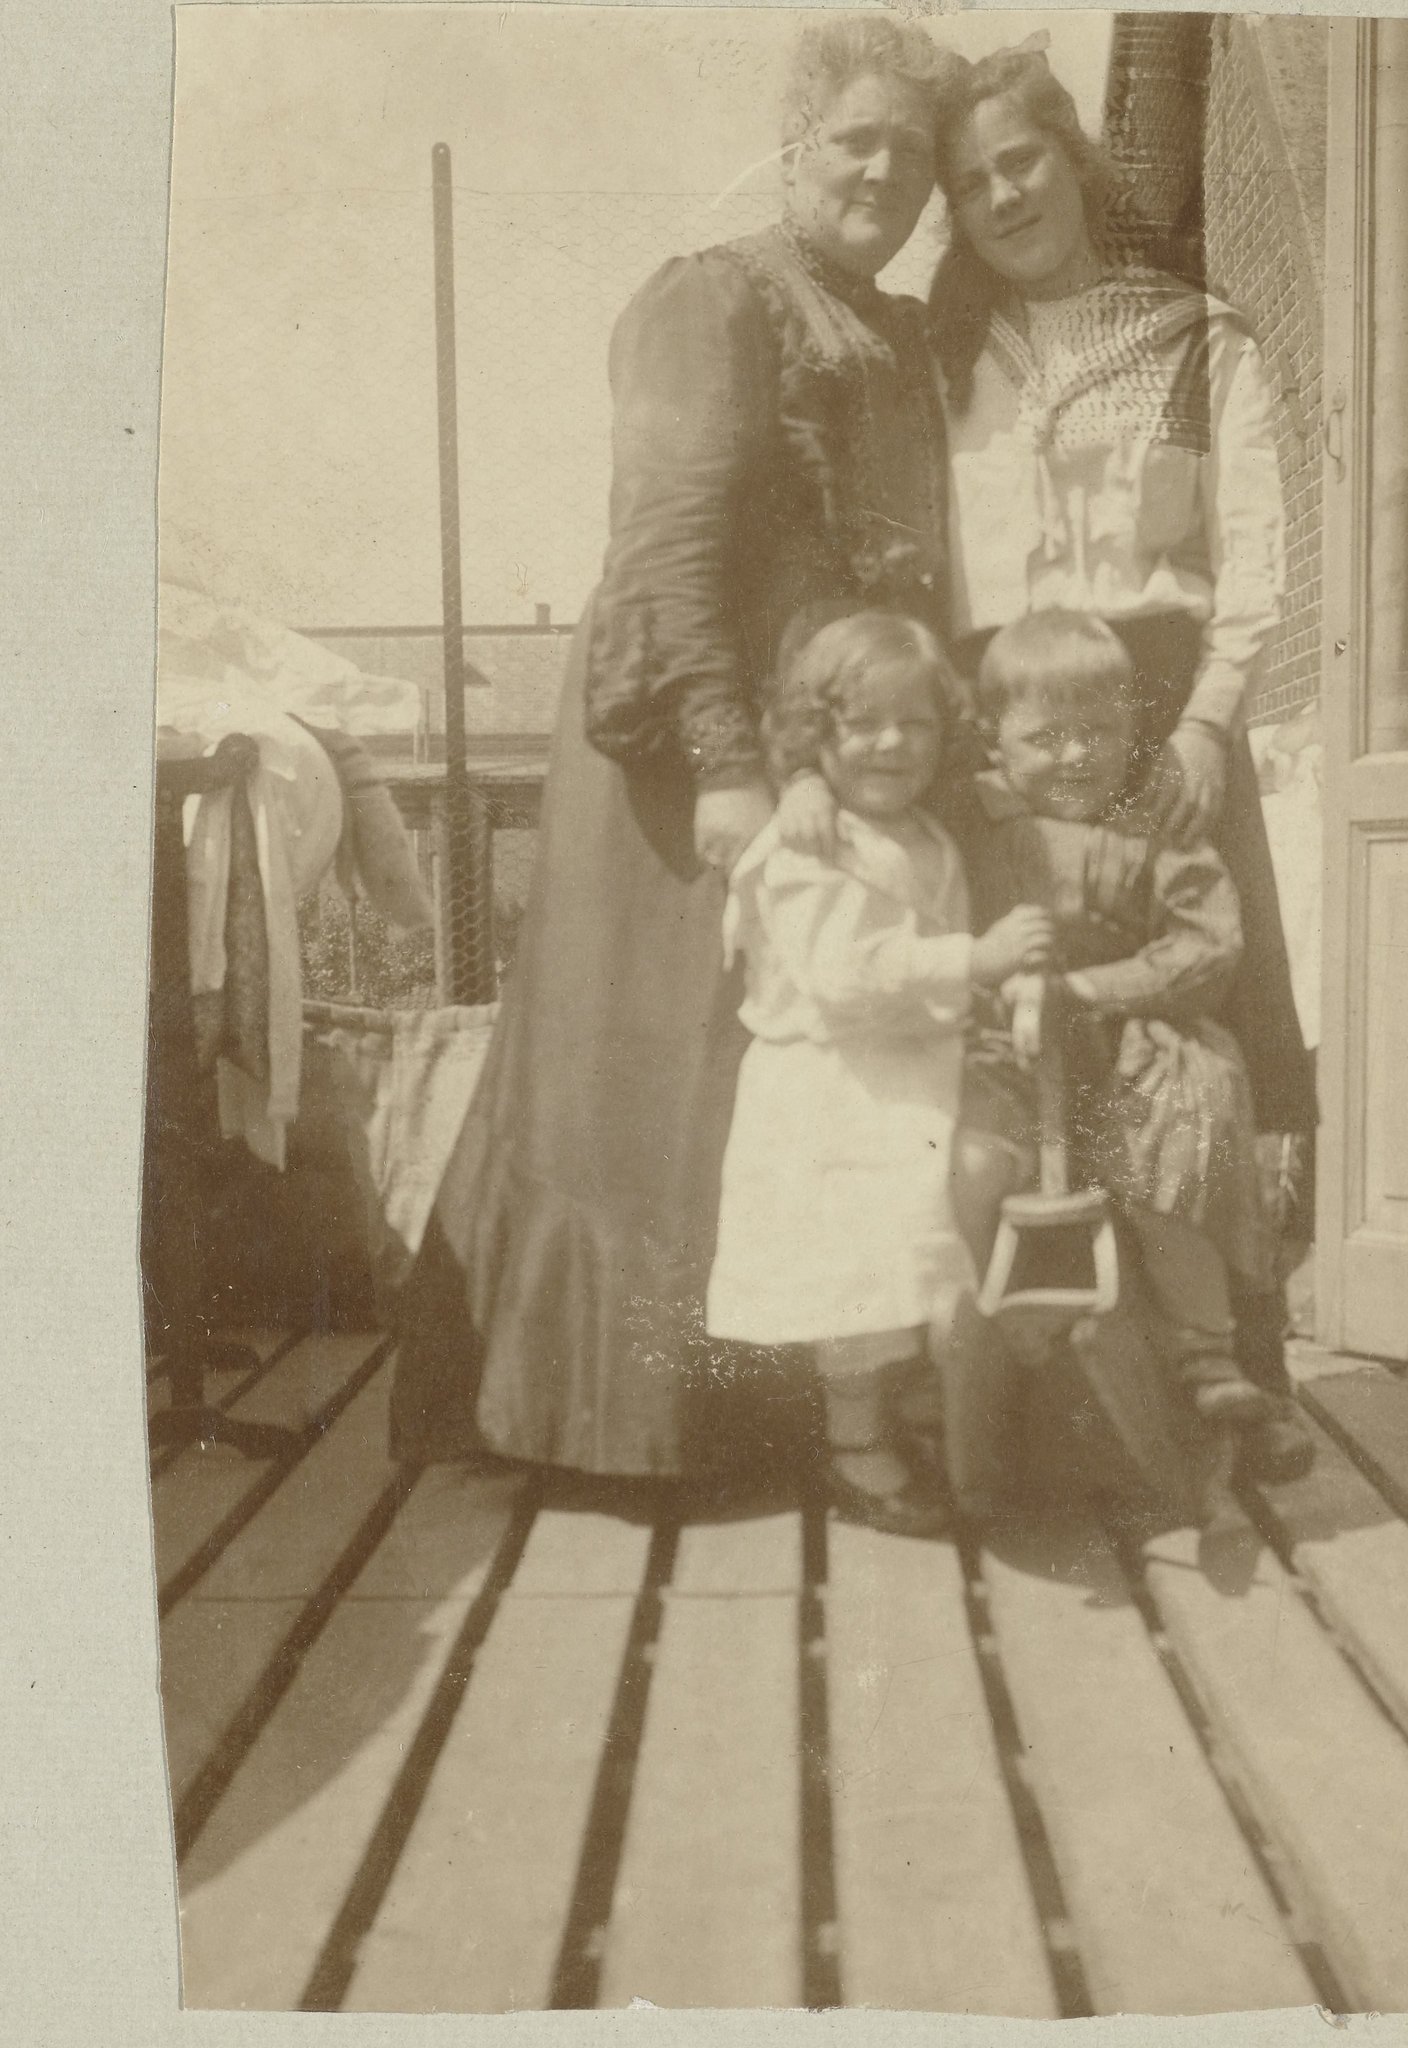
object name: album leaf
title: Groepsportret van Grietje Vermeulen-Luitjes en haar kinderen op een balkon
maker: david vermeulen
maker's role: fotograaf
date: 1901-1910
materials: paper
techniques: gelatin silver print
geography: the hague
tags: family group, especially parents with their child(ren), balcony